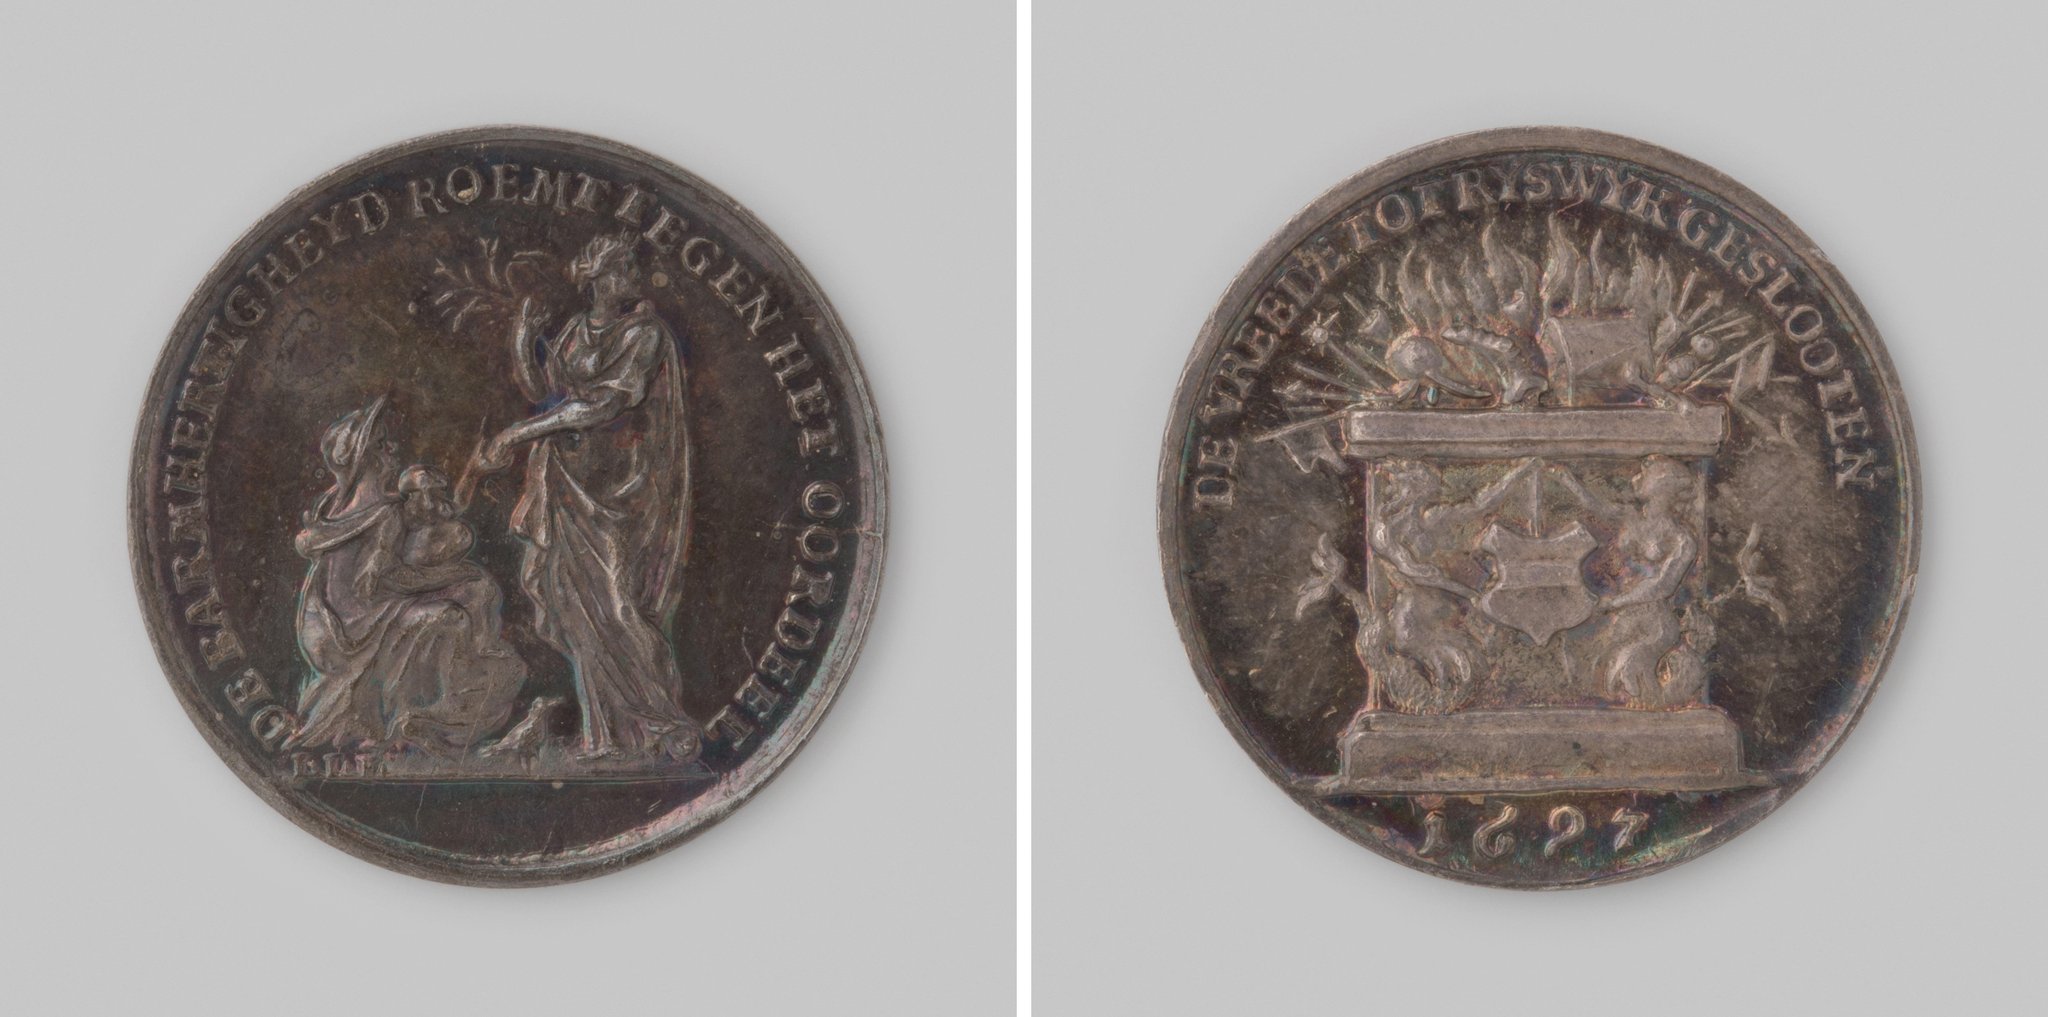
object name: history medal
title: Vrede van Rijswijk 1697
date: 1697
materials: silver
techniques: striking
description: Zilveren penninkje, op de voorzijde de Barmhartigheid met vredestak die moeder met kind troost (rechts een vogeltje), met omschrift, op de keerzijde een altaar, versierd met het wapen van Muiden, waarop oorlogstuig verbrand wordt, met omschrift.